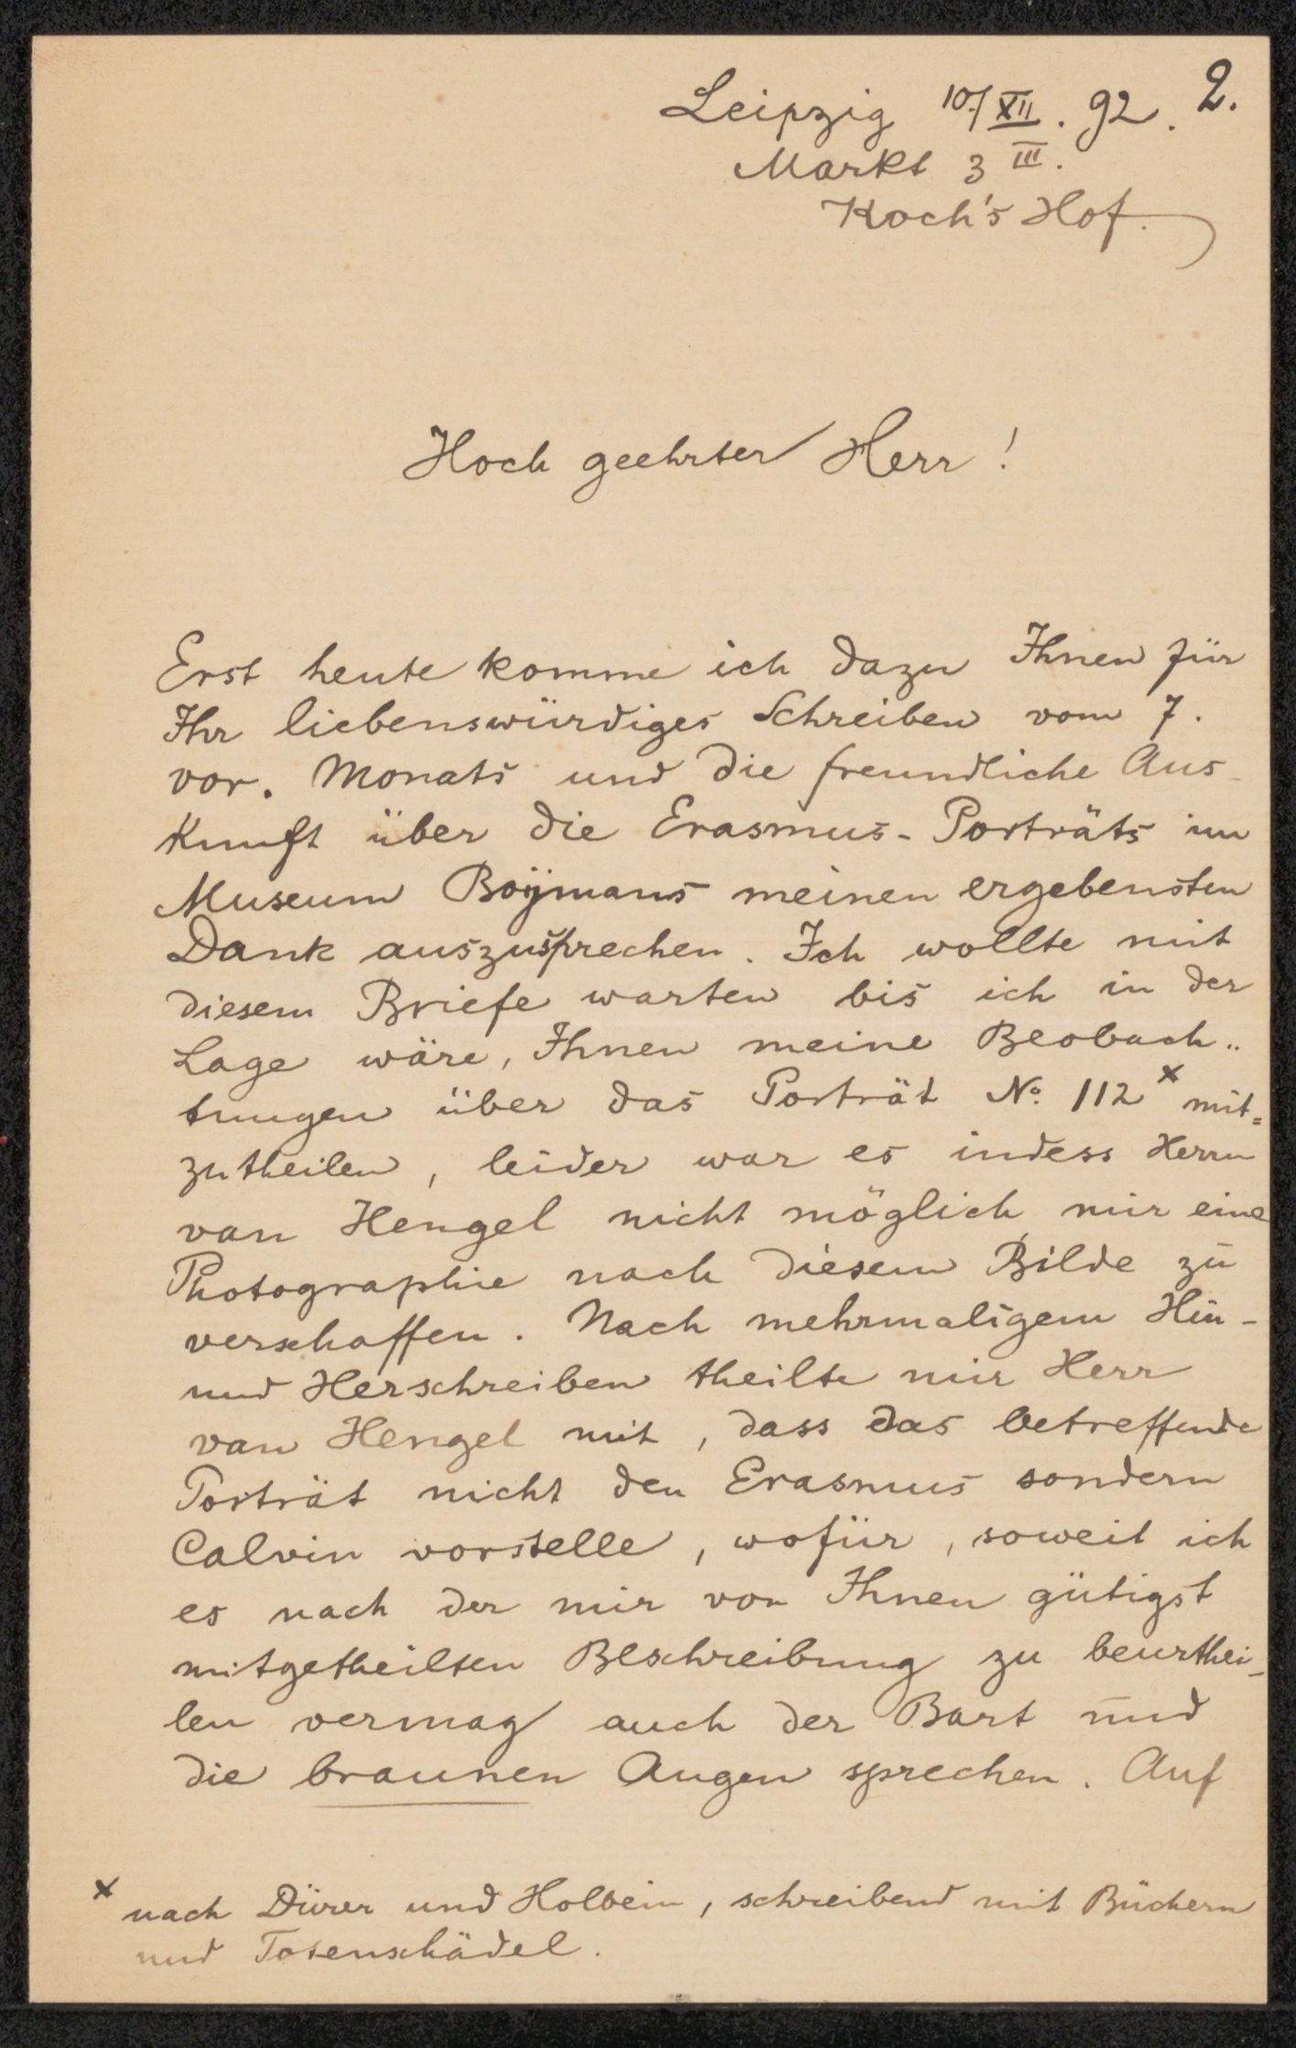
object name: letter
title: Brief aan Pieter Haverkorn van Rijsewijk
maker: julius r. haarhaus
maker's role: schrijver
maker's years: 1867-1947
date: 1892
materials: ink, paper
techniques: pen, writing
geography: leipzig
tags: rotterdam, desiderius erasmus, pieter haverkorn van rijsewijk, historical persons (portraits and scenes from the life)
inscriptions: watermark